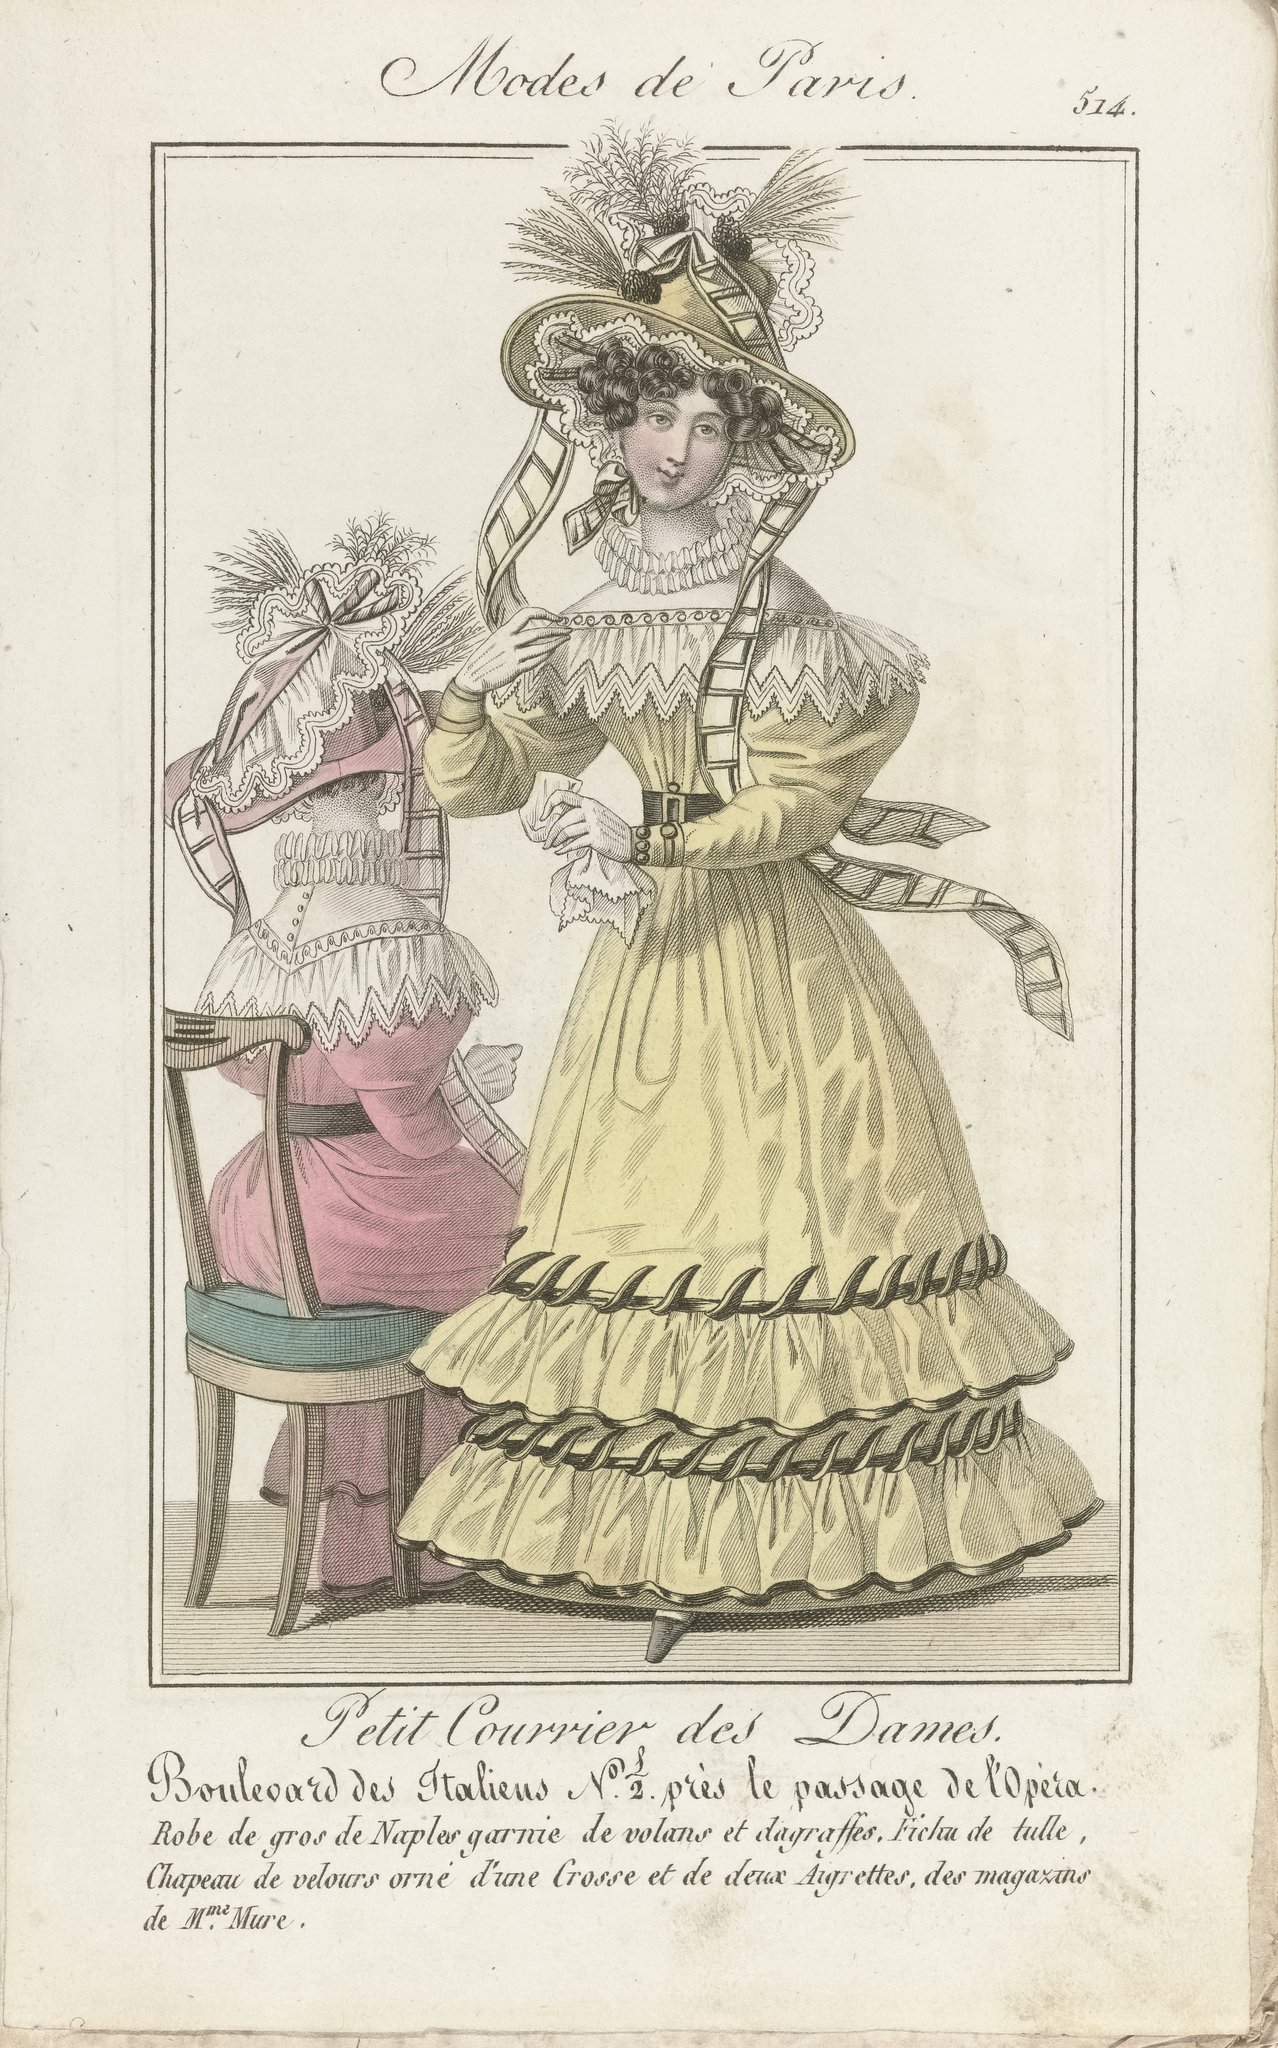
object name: magazine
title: Petit Courrier des Dames, 1827 (514)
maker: Anonymous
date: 1827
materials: paper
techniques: engraving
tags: fashion plates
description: Prent uit het modetijdschrift Petit Courrier des Dames (1821-1868).